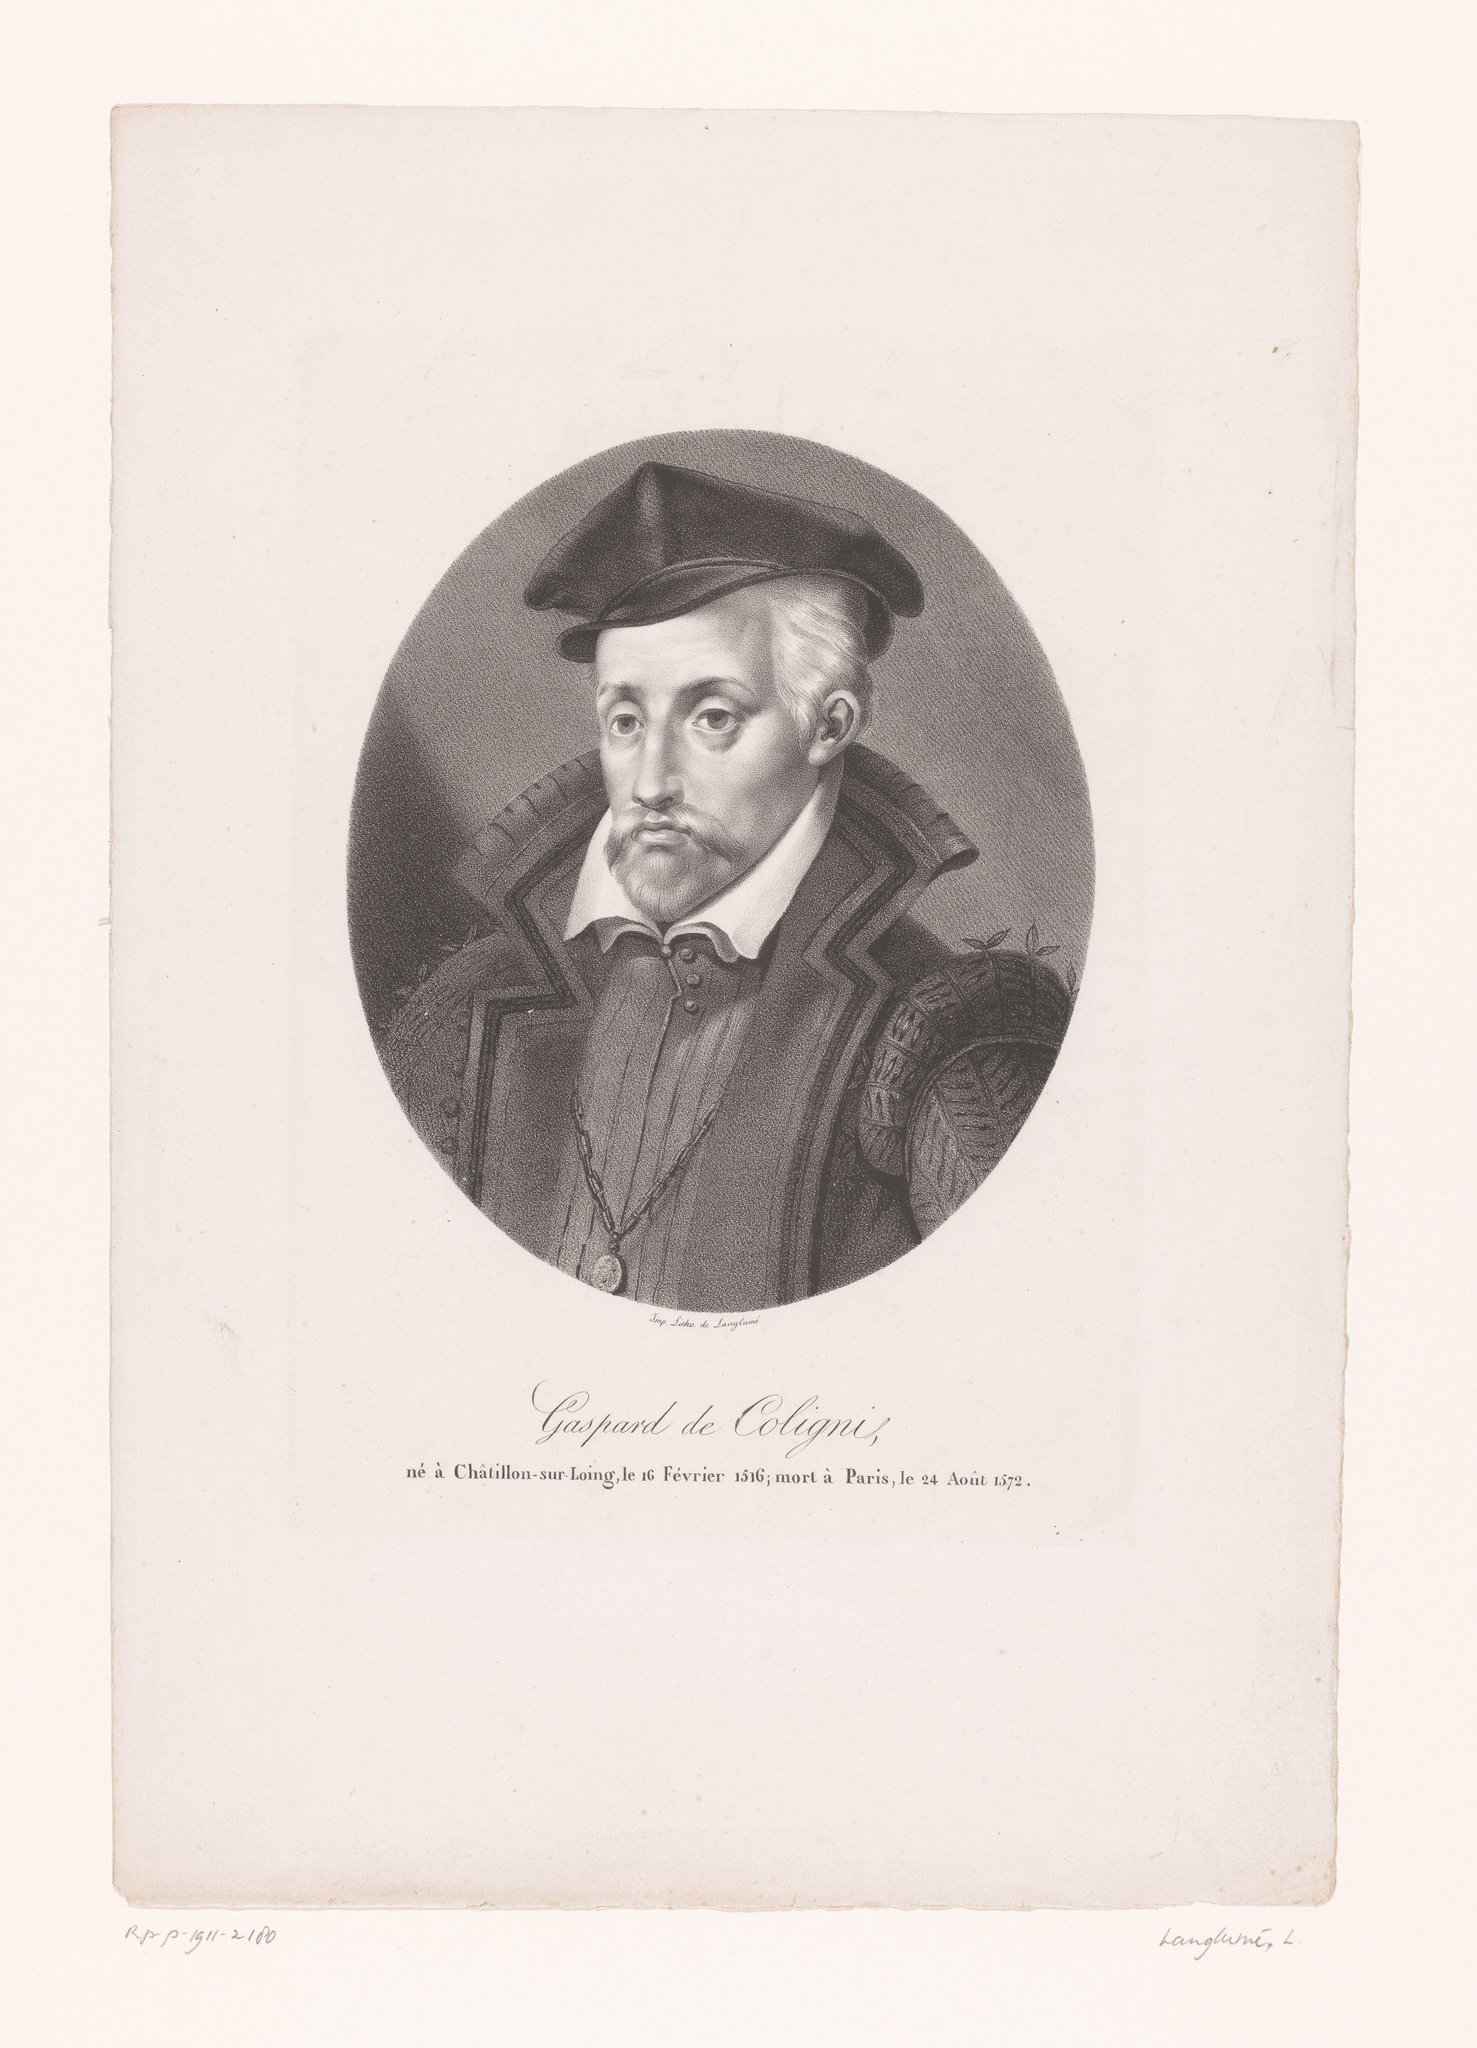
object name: print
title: Gaspard de Coligni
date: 1820-1830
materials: paper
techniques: lithograph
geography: paris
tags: paris, politician, gaspard de coligny (ii), historical persons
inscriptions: collector's mark: Lugt 2228a